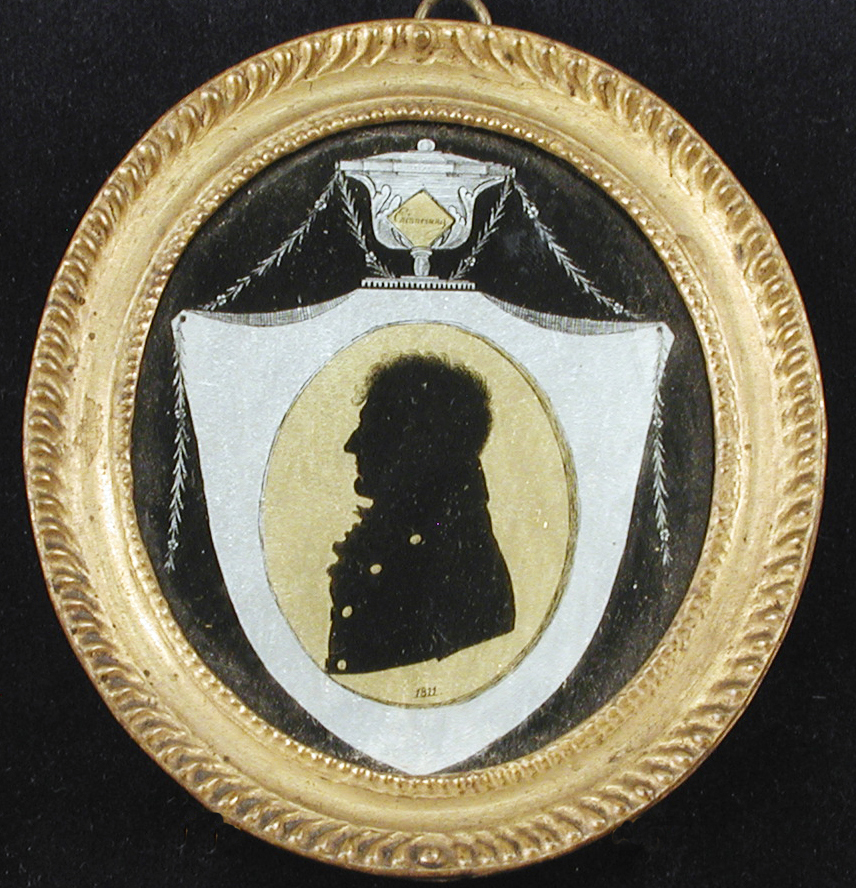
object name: medallion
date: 1811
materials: glass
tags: men,profiles